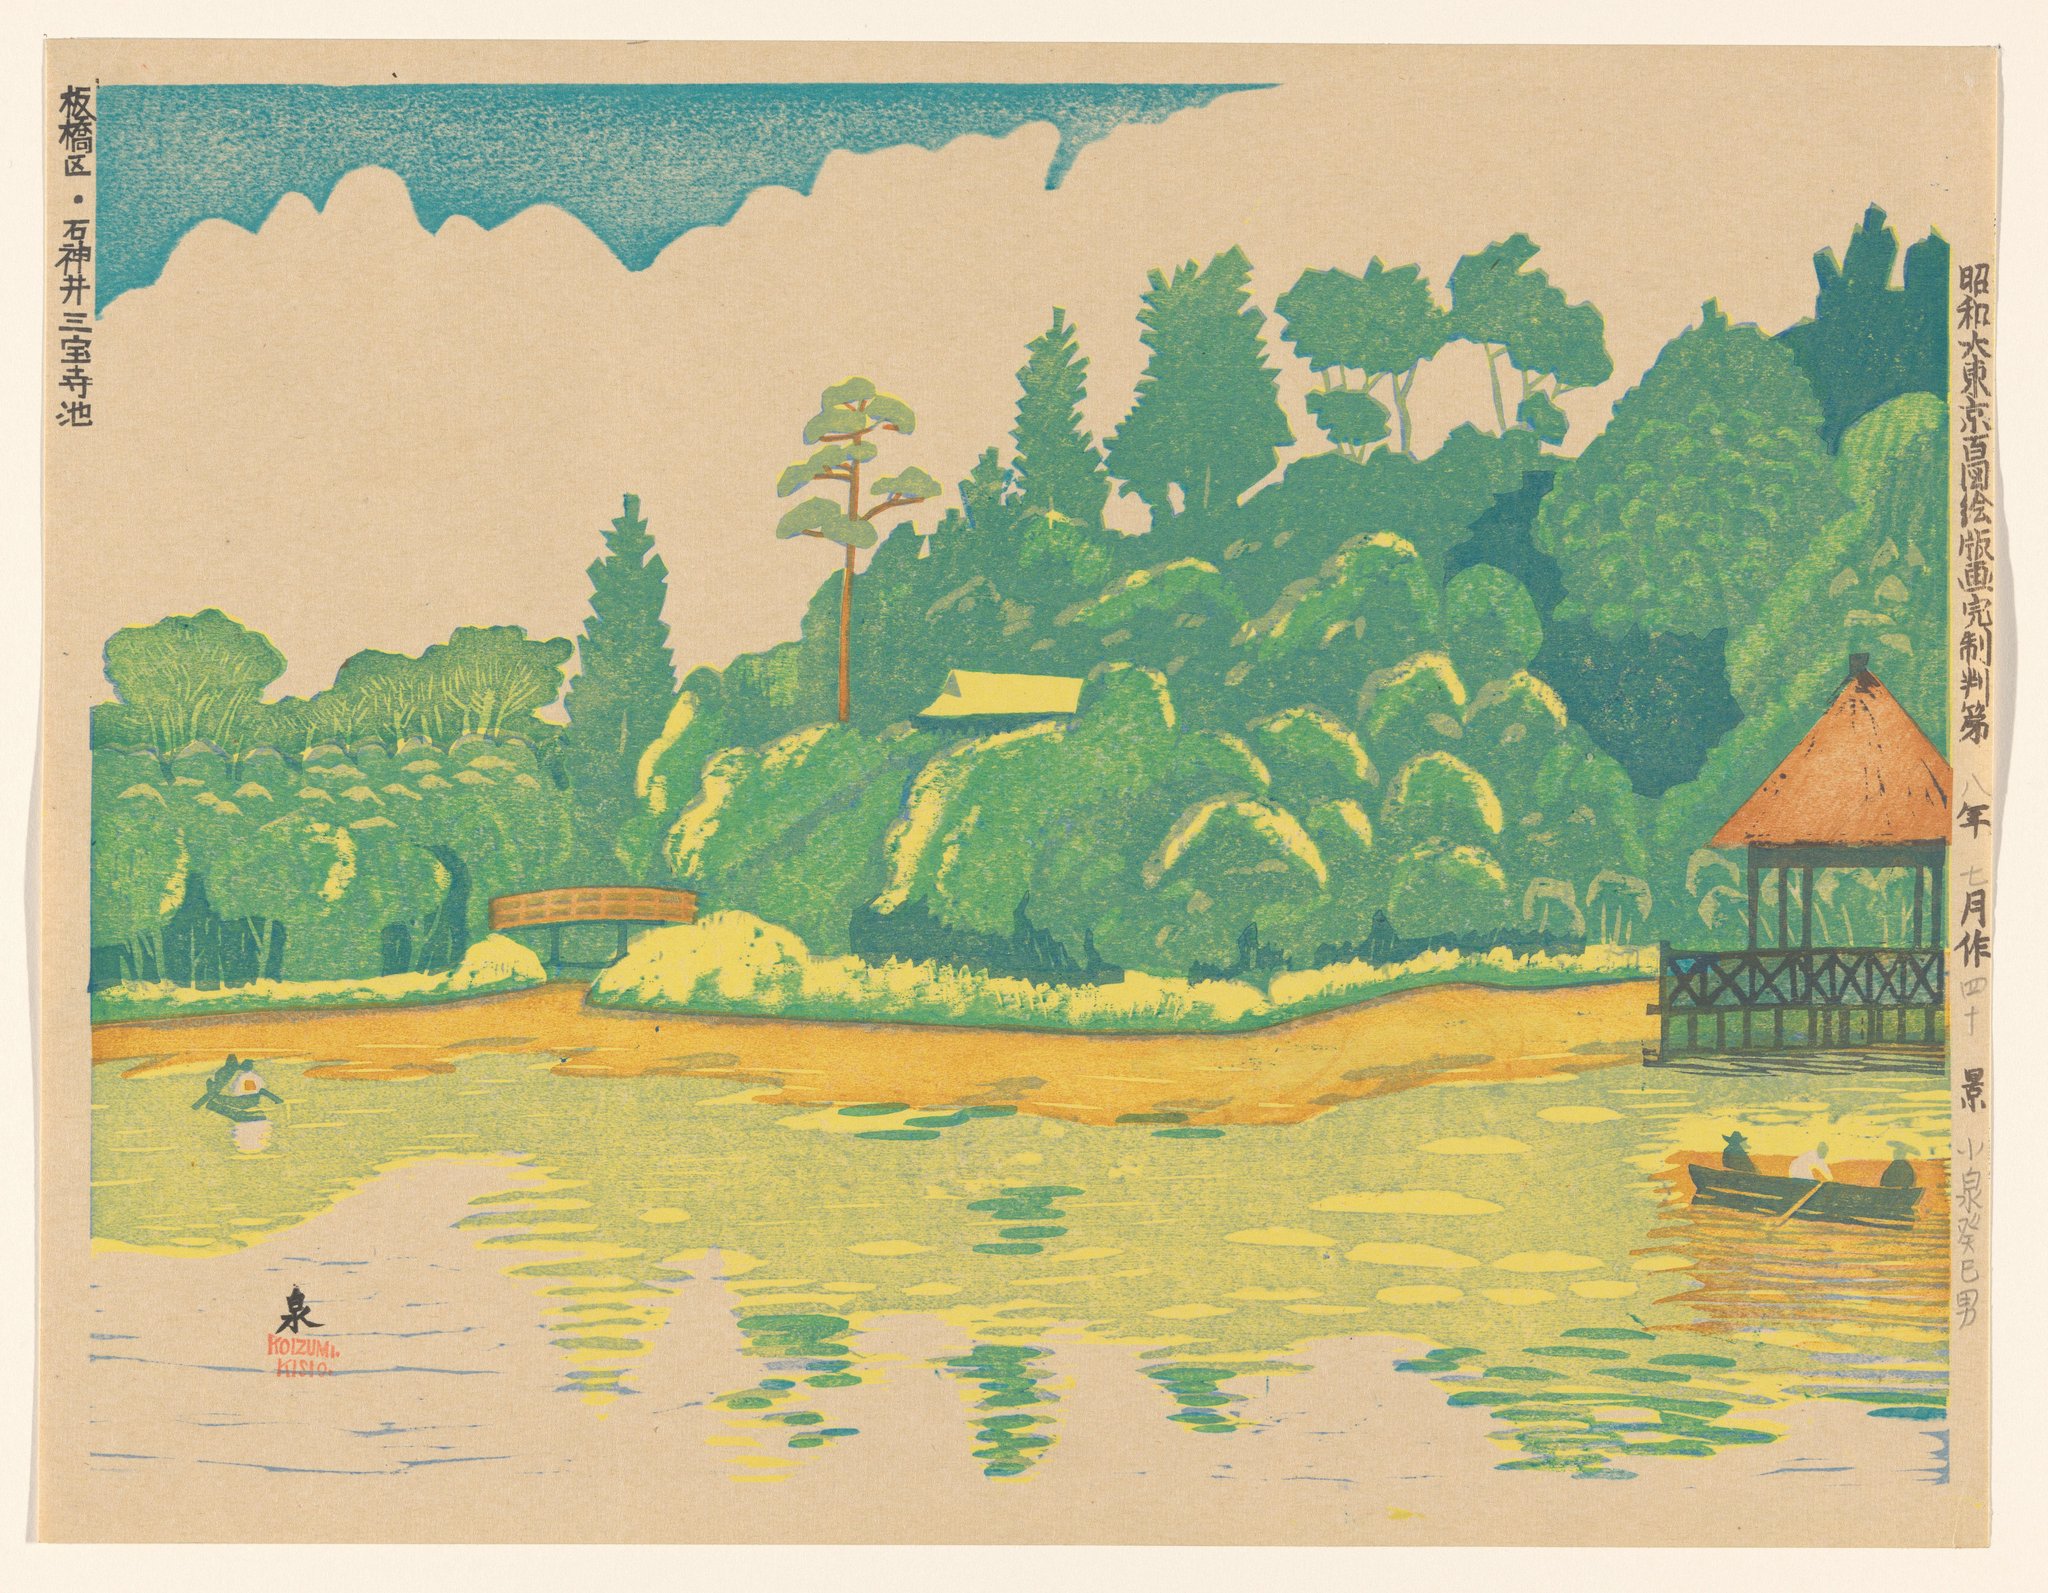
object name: print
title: One hundred pictures of Great Tokyo in the Shōwa era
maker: koizumi kishio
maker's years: 1893-1945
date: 1907-1933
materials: paper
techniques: woodcut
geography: japan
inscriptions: seal: ‘Koizumi Kisio’, signature: ‘小泉癸巳男’, signature: ‘泉’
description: Een gezicht op een grote vijver, die geel en groen kleurt door de weerspiegeling van de omringende bebossing. Twee plezierbootjes varen rechts en links op het water. In september 1928 begon Koizumi Kishio aan zijn ambitieuze plan om honderd landschapsprenten met scènes in Tokyo volledig zelf te ontwerpen, hiervan zelf de drukblokken te snijden en zelf de prenten te drukken. De aanleiding voor het project was grote verandering die Tokyo onderging door de verwoestende Grote Kantō-aardbeving van 1923 en de wederopbouw die daarop volgde. Kishio maakt een bewuste verwijzing naar de bekende serie ‘Honderd beroemde gezichten op Edo’ door Utagawa Hiroshige (1797–1858), met prenten van locaties in Edo—de oude benaming voor Tokyo. Kishio toont overwegend moderne gebouwen, instituten en mensen die de tijdsgeest van de jaren 1920 en 1930 weerspiegelen. Sommige prenten onthullen daarentegen een nostalgische blik op overblijfselen uit het oude Edo. Kishio verkocht de prenten aan de hand van een abonnement met een limiet van vijftig leden, die elke maand een of twee prenten zouden ontvangen. Het project begon met negen abonnementen, maar al na de tweede maand werden meerdere daarvan opgezegd en slechts vier mecenassen bleven lid tot en met de voltooiing van de serie. Hij bracht het honderdste ontwerp uit in 1937. Zijn leermeester Ishii Hakutei schreef een inleiding in 1938 die Kishio verwerkte tot een prent en toevoegde aan de set. Tussen 1939 en 1940 maakte hij nog eens negen extra ontwerpen. Met acht van deze ontwerpen verving hij oudere nummers uit de serie, mogelijk omdat hij niet tevreden was met de composities. Uiteindelijk lukte het Kishio om tien complete sets te verkopen aan de shin hanga-uitgever Watanabe Shōzaburō en liet hiervoor speciale houten dozen maken. Deze prent behoort tot een van die tien sets.